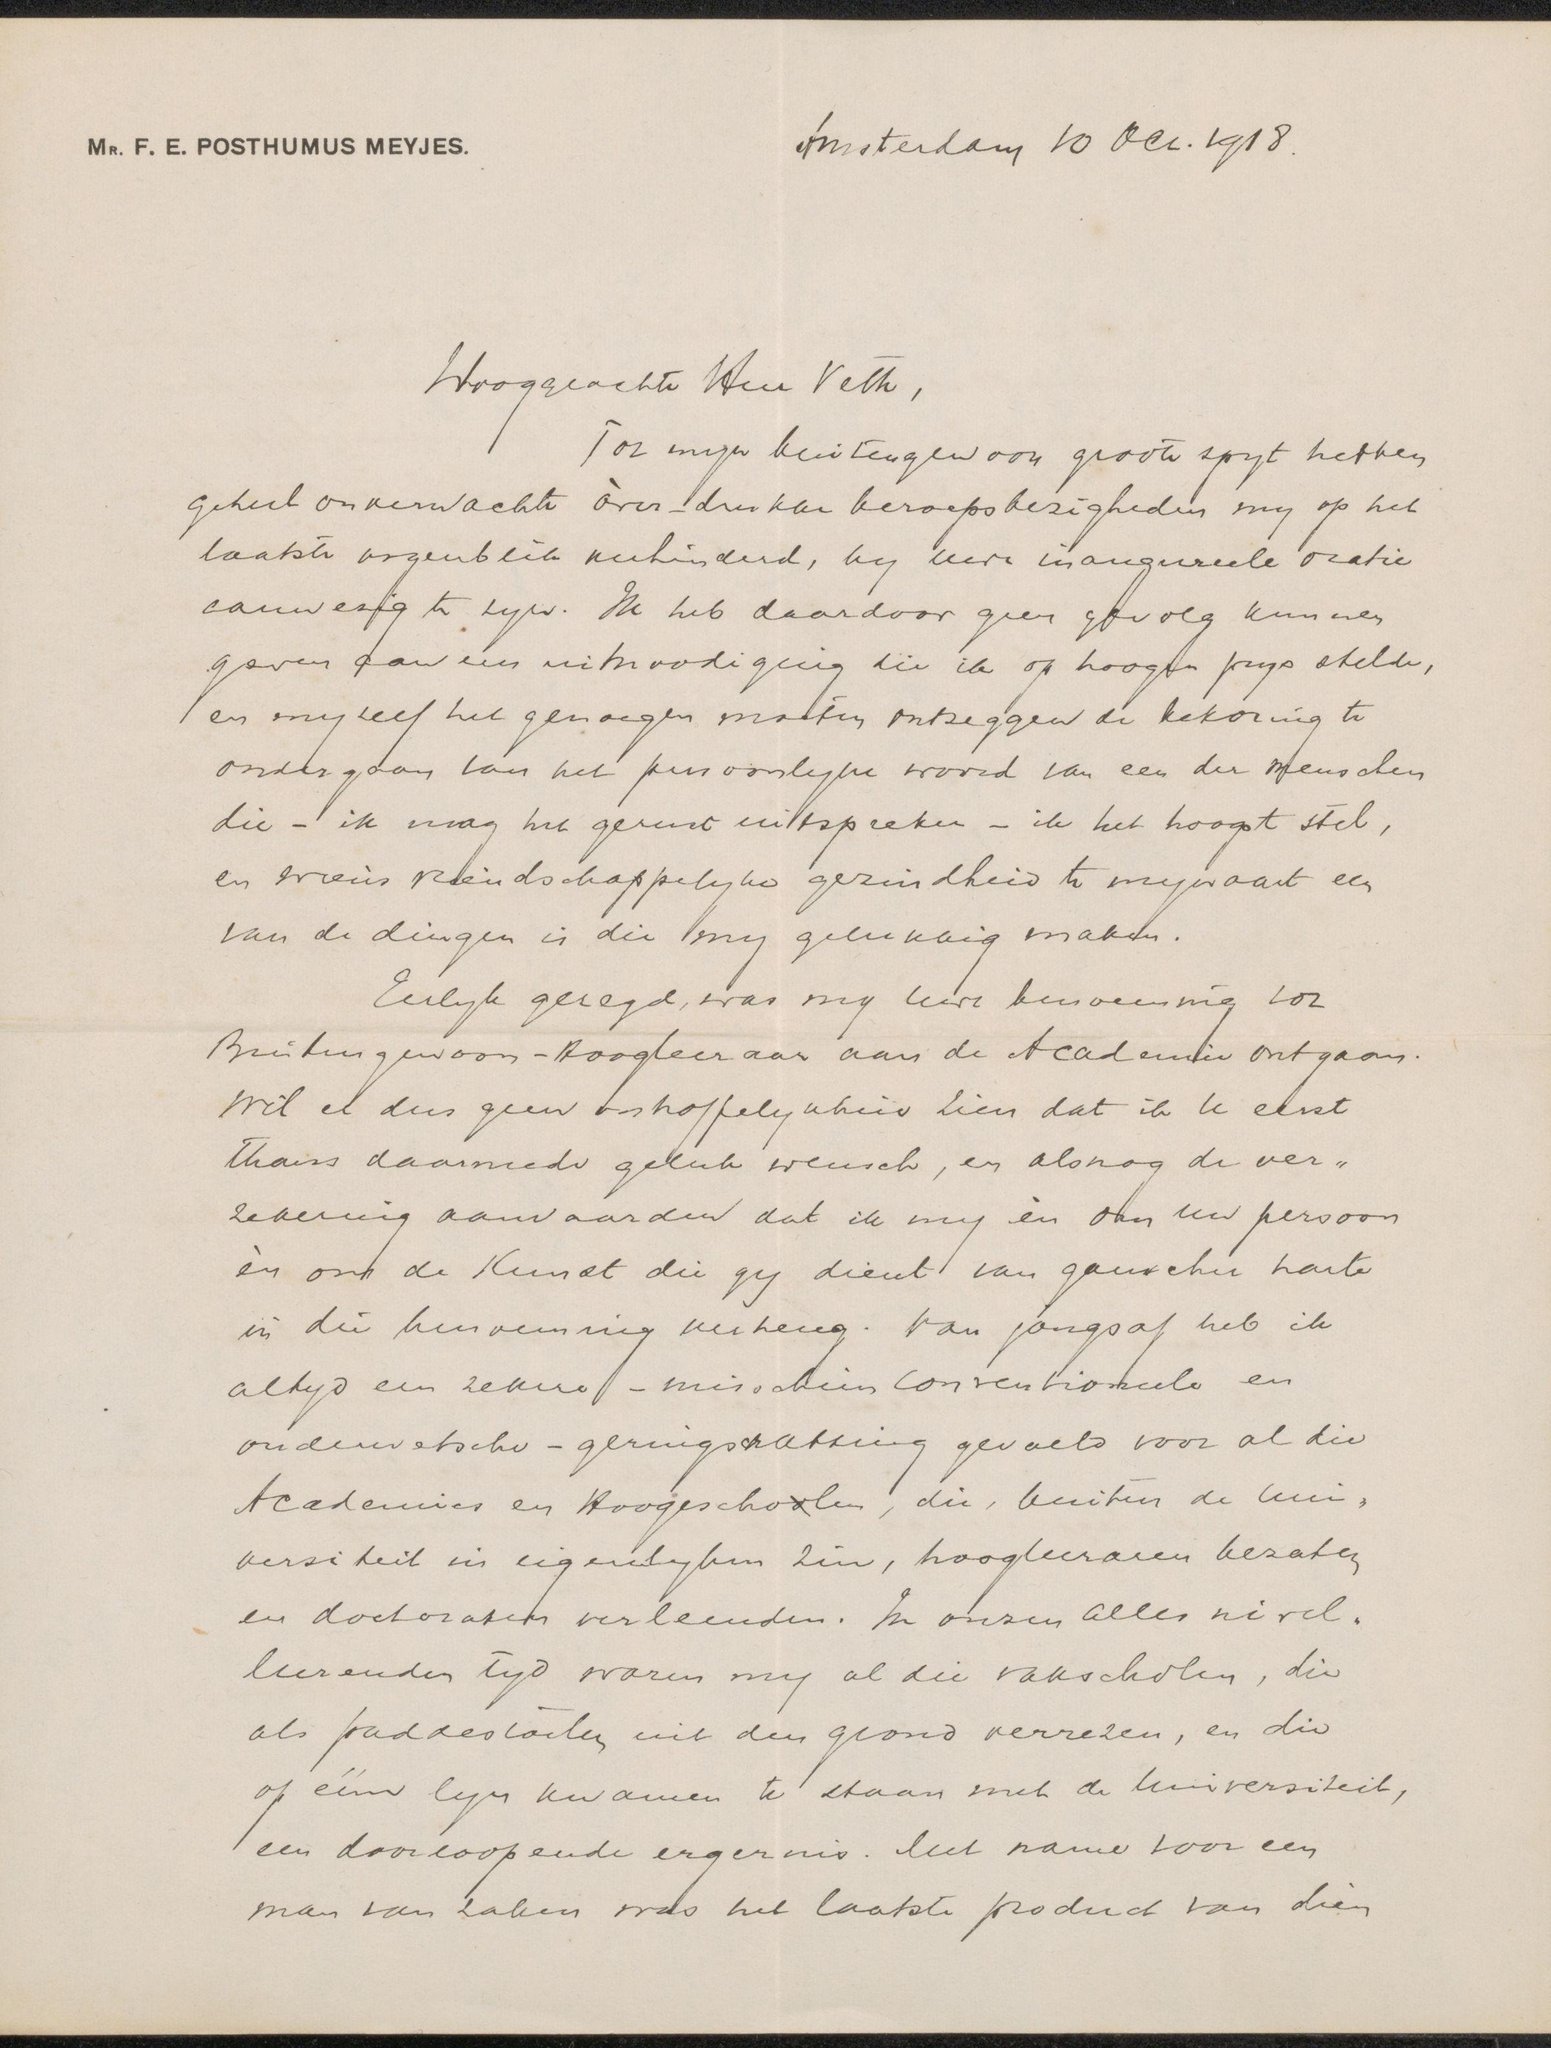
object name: letter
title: Brief aan Jan Veth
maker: f.e. posthumus meyjes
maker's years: 1865-1926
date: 1918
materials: ink, paper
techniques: pen, printing, writing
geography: amsterdam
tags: dordrecht, painter, print maker, draughtsman, designer, jan veth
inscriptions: collector's mark: ‘RPK’, name: ‘Mr. F.E. POSTHUMUS MEYJES.’, watermark